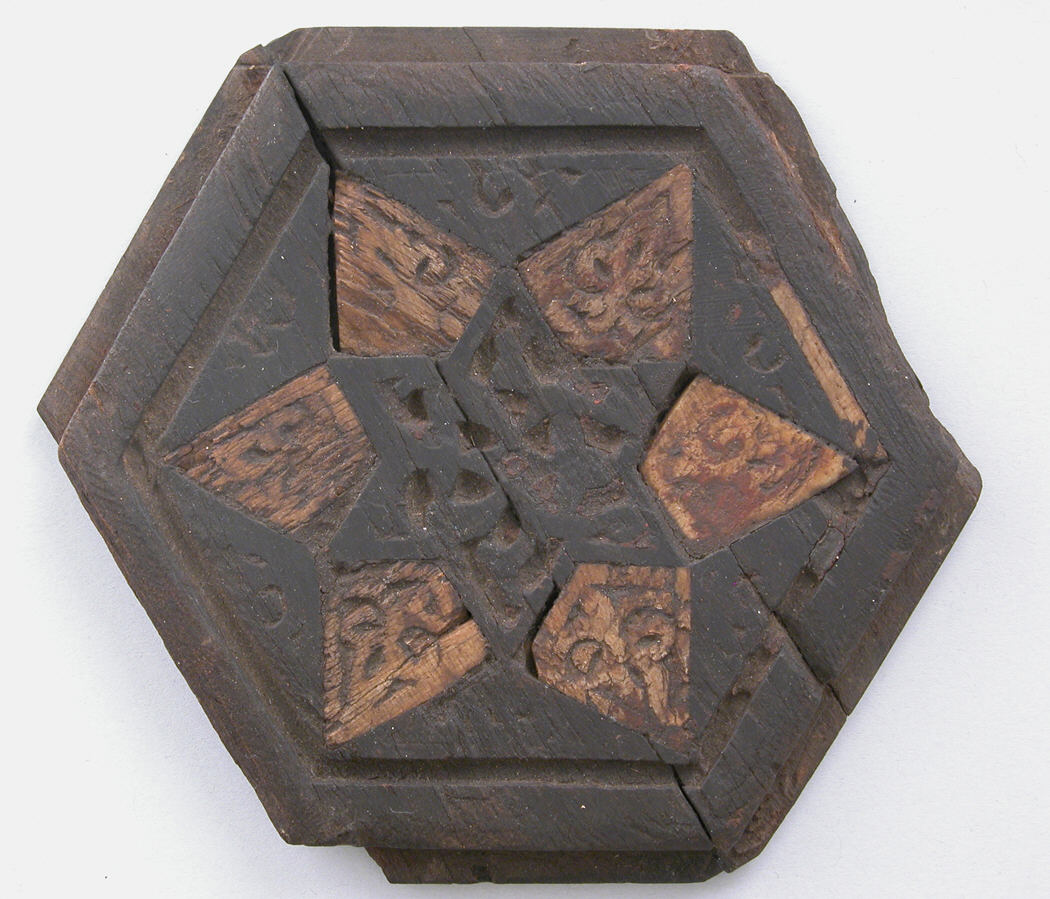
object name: panel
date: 1301-1500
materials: ivory, wood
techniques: carving, inlay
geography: egypt